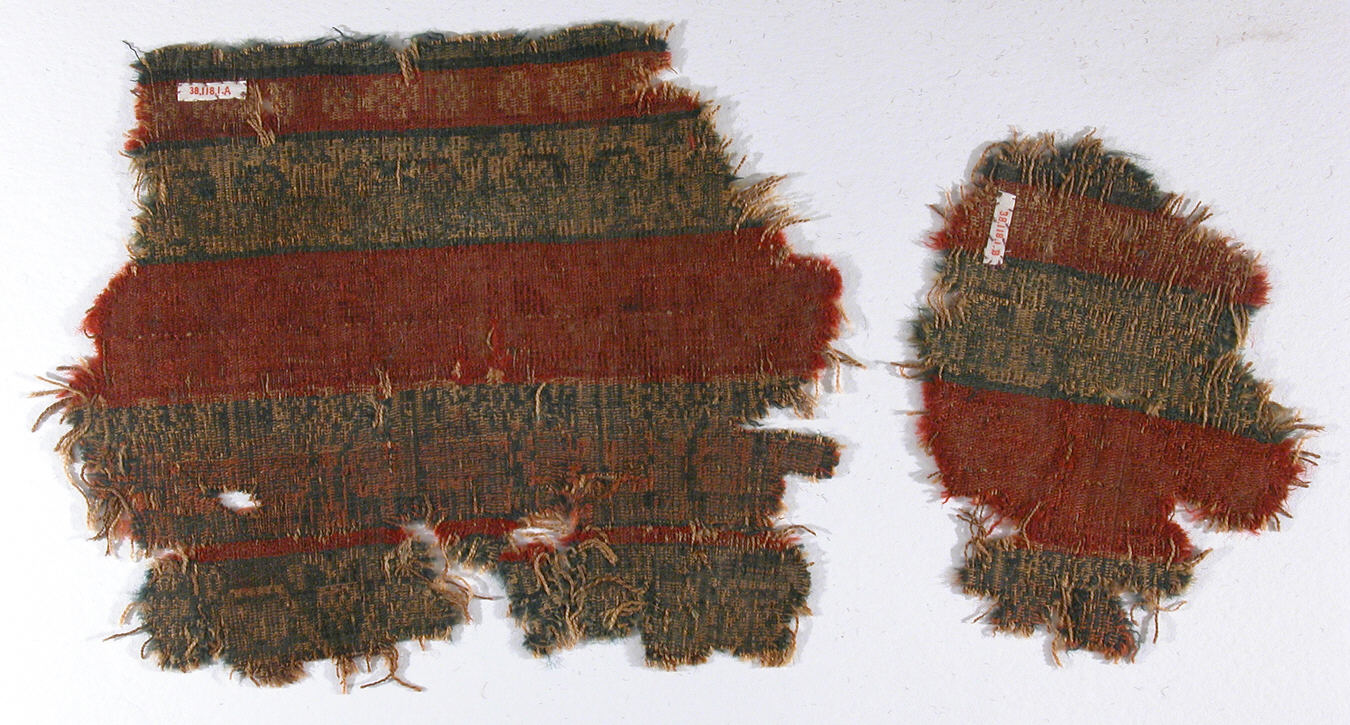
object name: textile fragment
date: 501-700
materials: wool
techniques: weave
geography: egypt